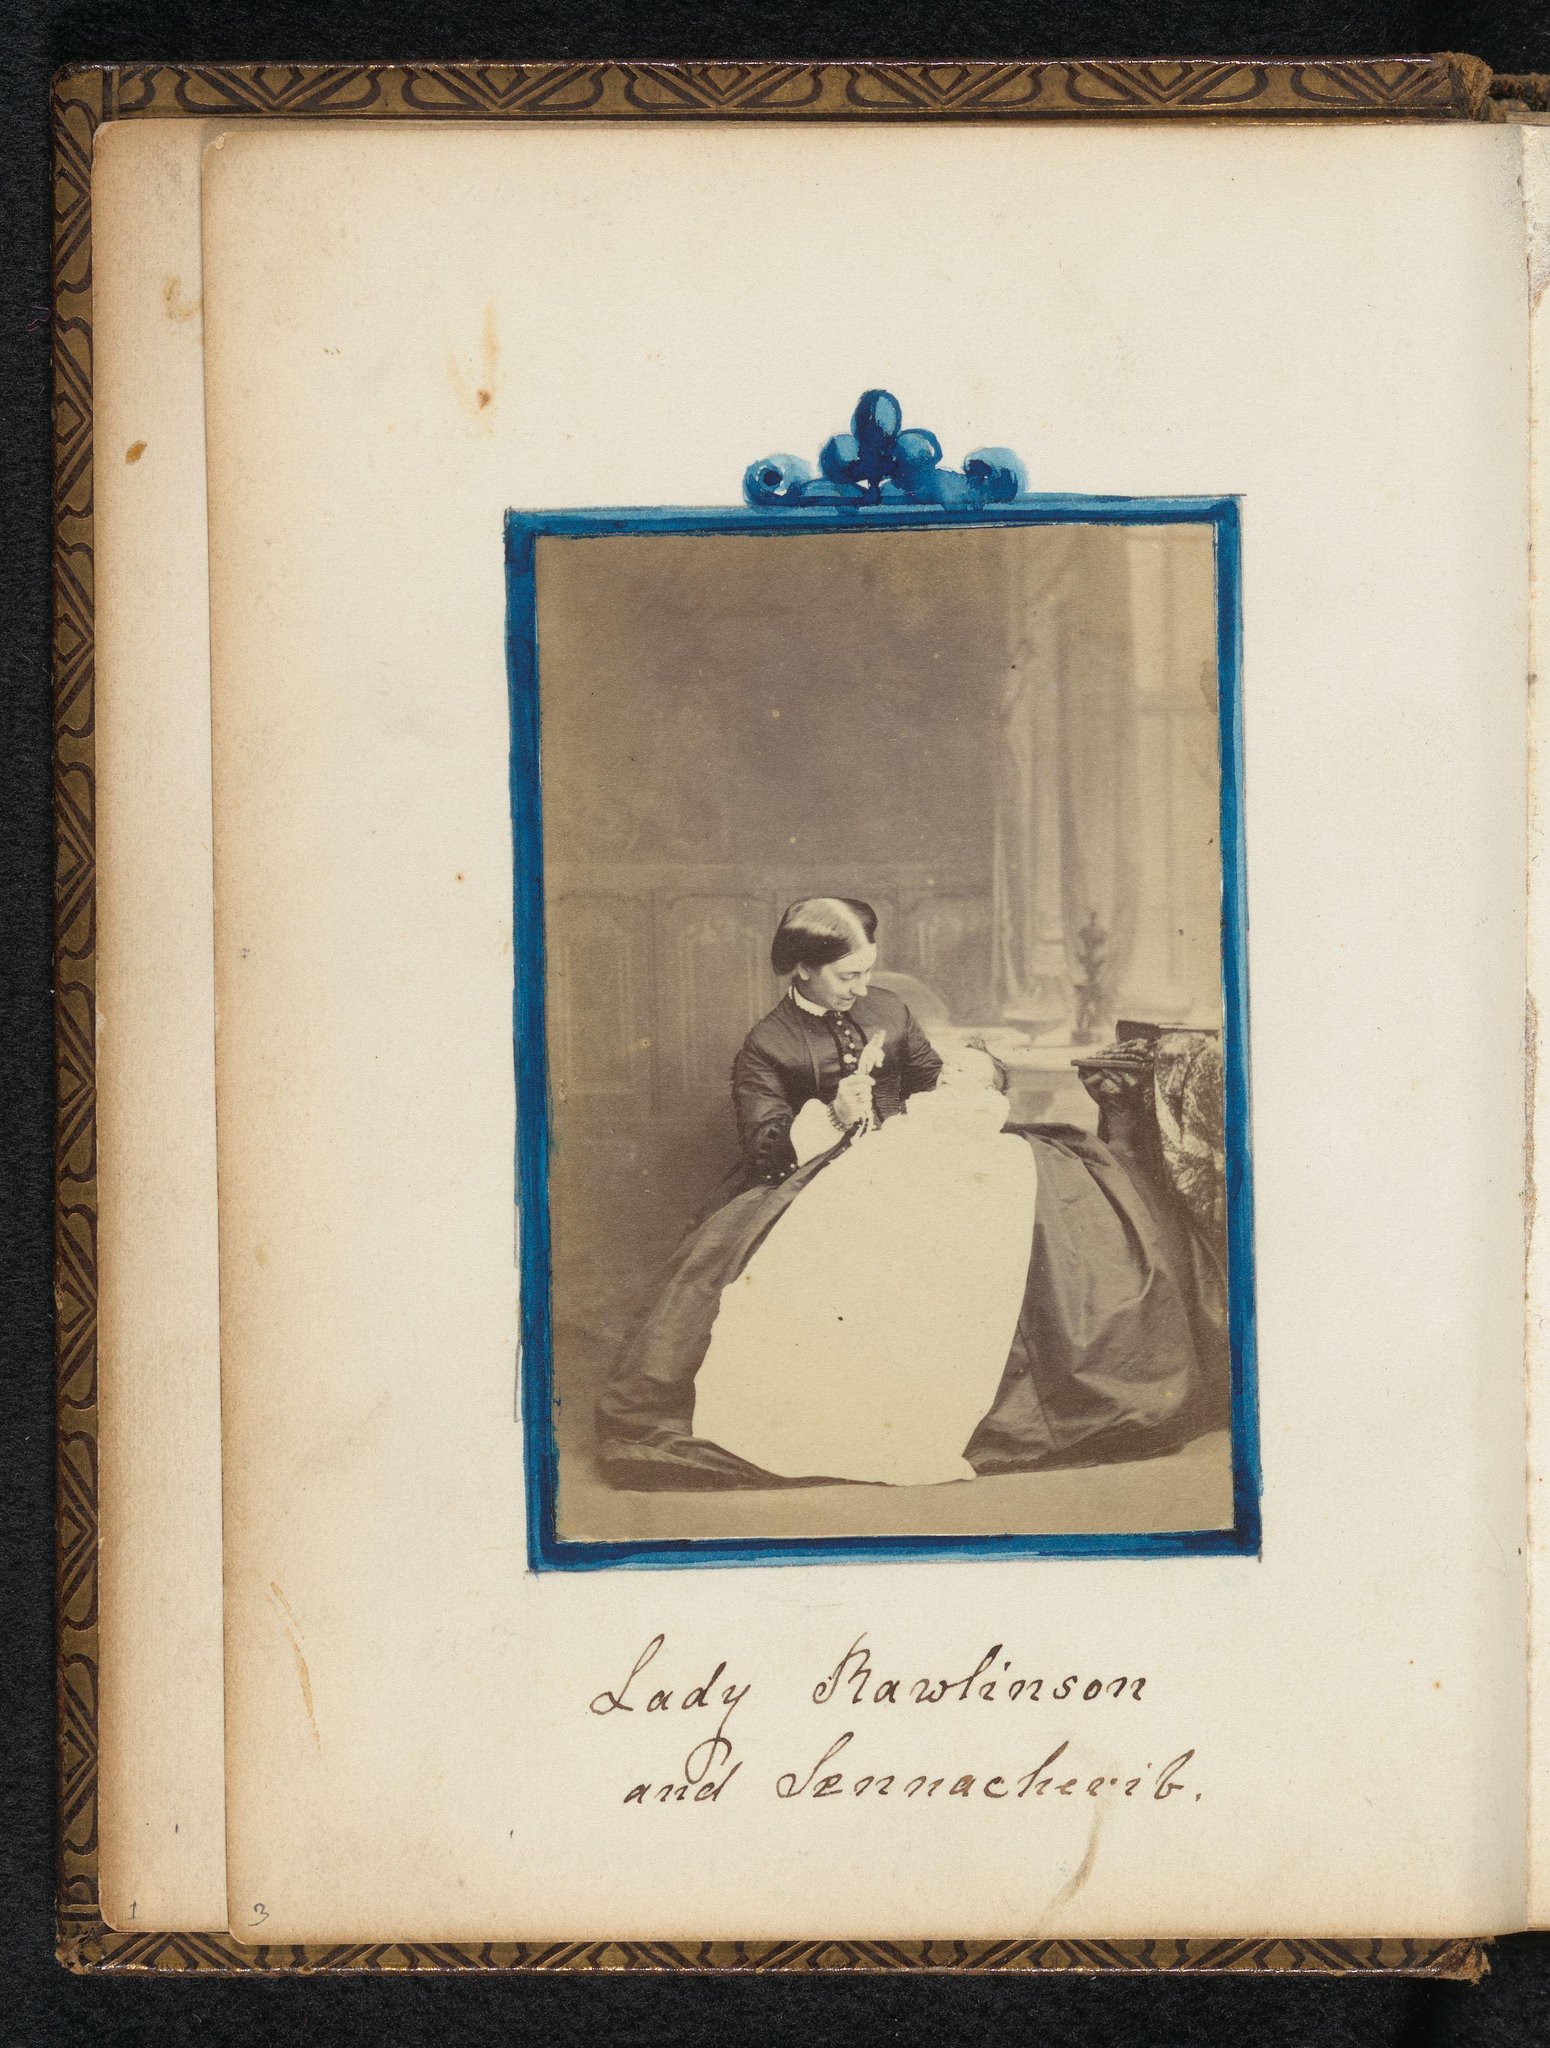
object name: album leaf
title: Lady Rawlinson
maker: Anonymous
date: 1865-1867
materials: cardboard, photographic support, watercolor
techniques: albumen print, aquarelle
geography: england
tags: historical persons - bb - woman, mother and baby or young child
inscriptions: annotation: ‘Lady Rawlinson and Sennacherib’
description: Portret van Louisa Caroline Harcourt Seymour, Lady Rawlinson, met baby Sennacherib. Foto op albumblad in album met 68 foto's merendeels met geaquarelleerde randversieringen. Het zijn voornamelijk portretten op carte-de-visite formaat.